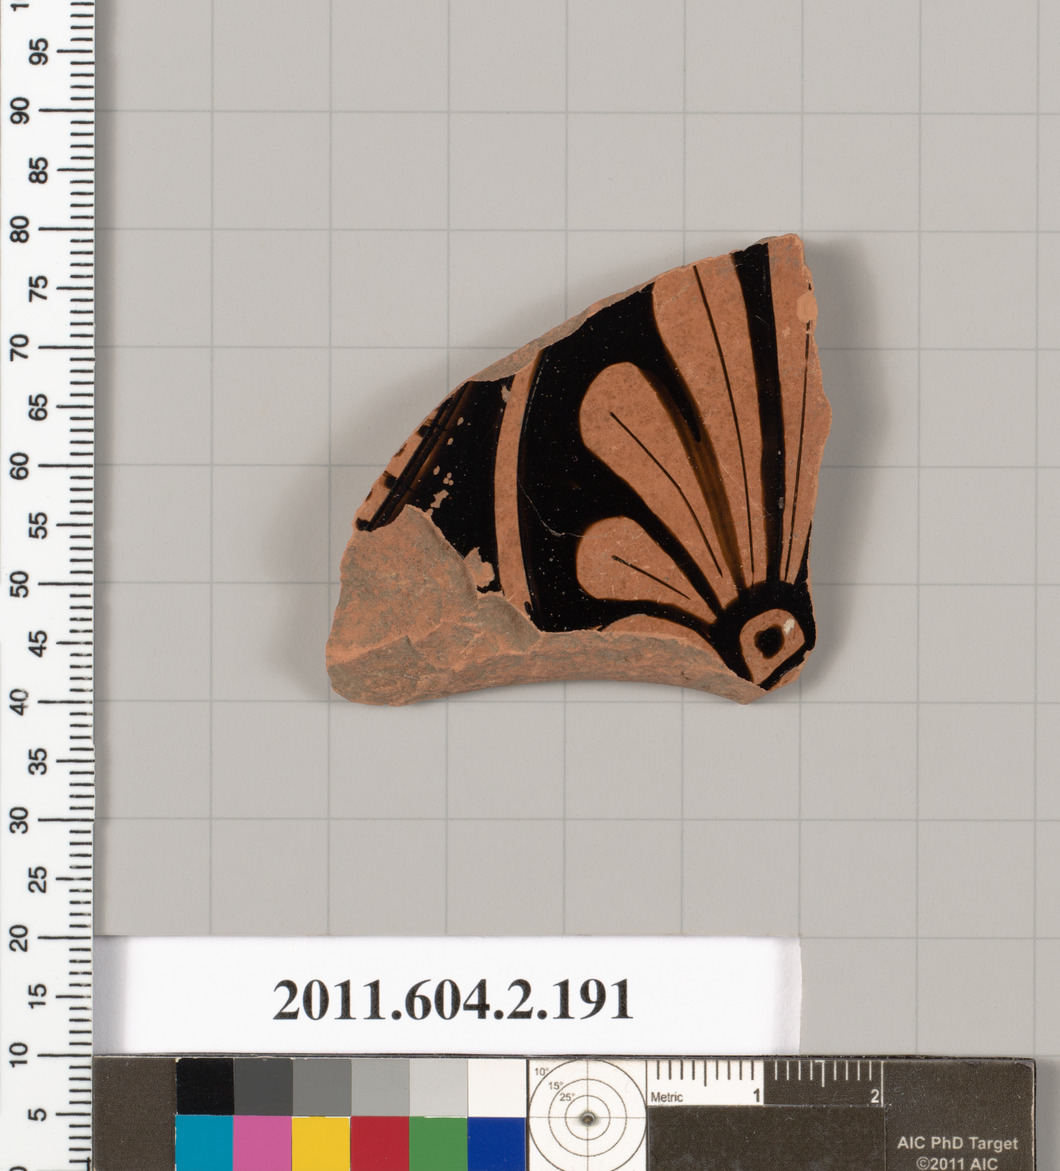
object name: stamnos fragment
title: Terracotta fragment of a stamnos (jar)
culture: greek, attic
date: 520-510 BCE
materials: terracotta